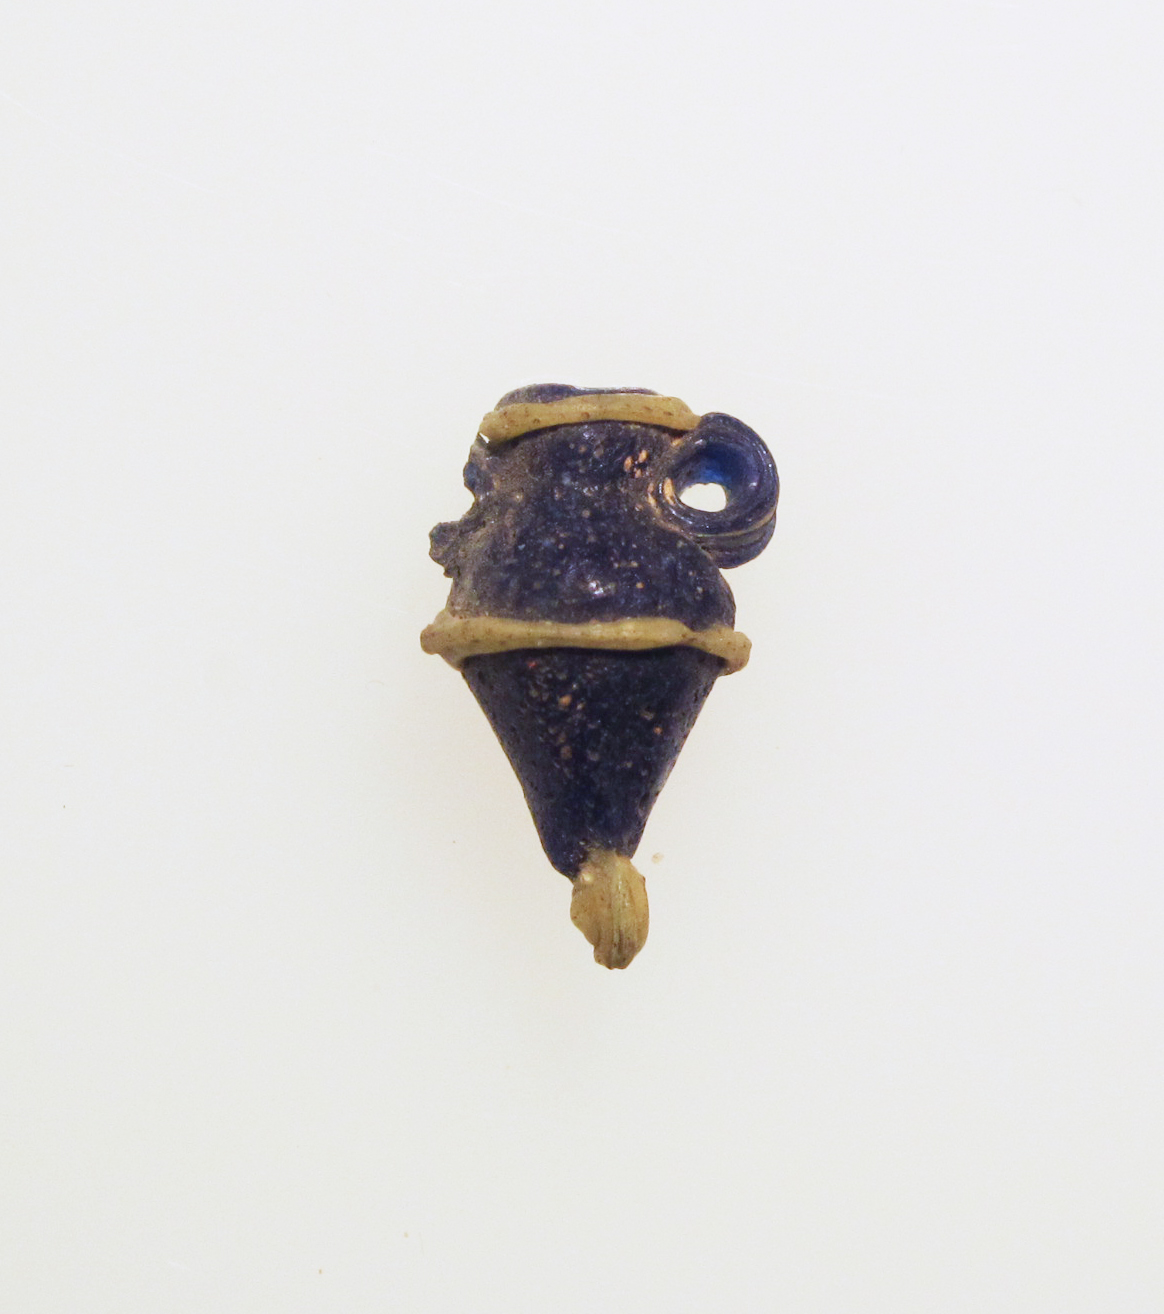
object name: pendant in the form of an amphora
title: Glass pendant in the form of an amphora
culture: phoenician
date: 760-140 BCE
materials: glass